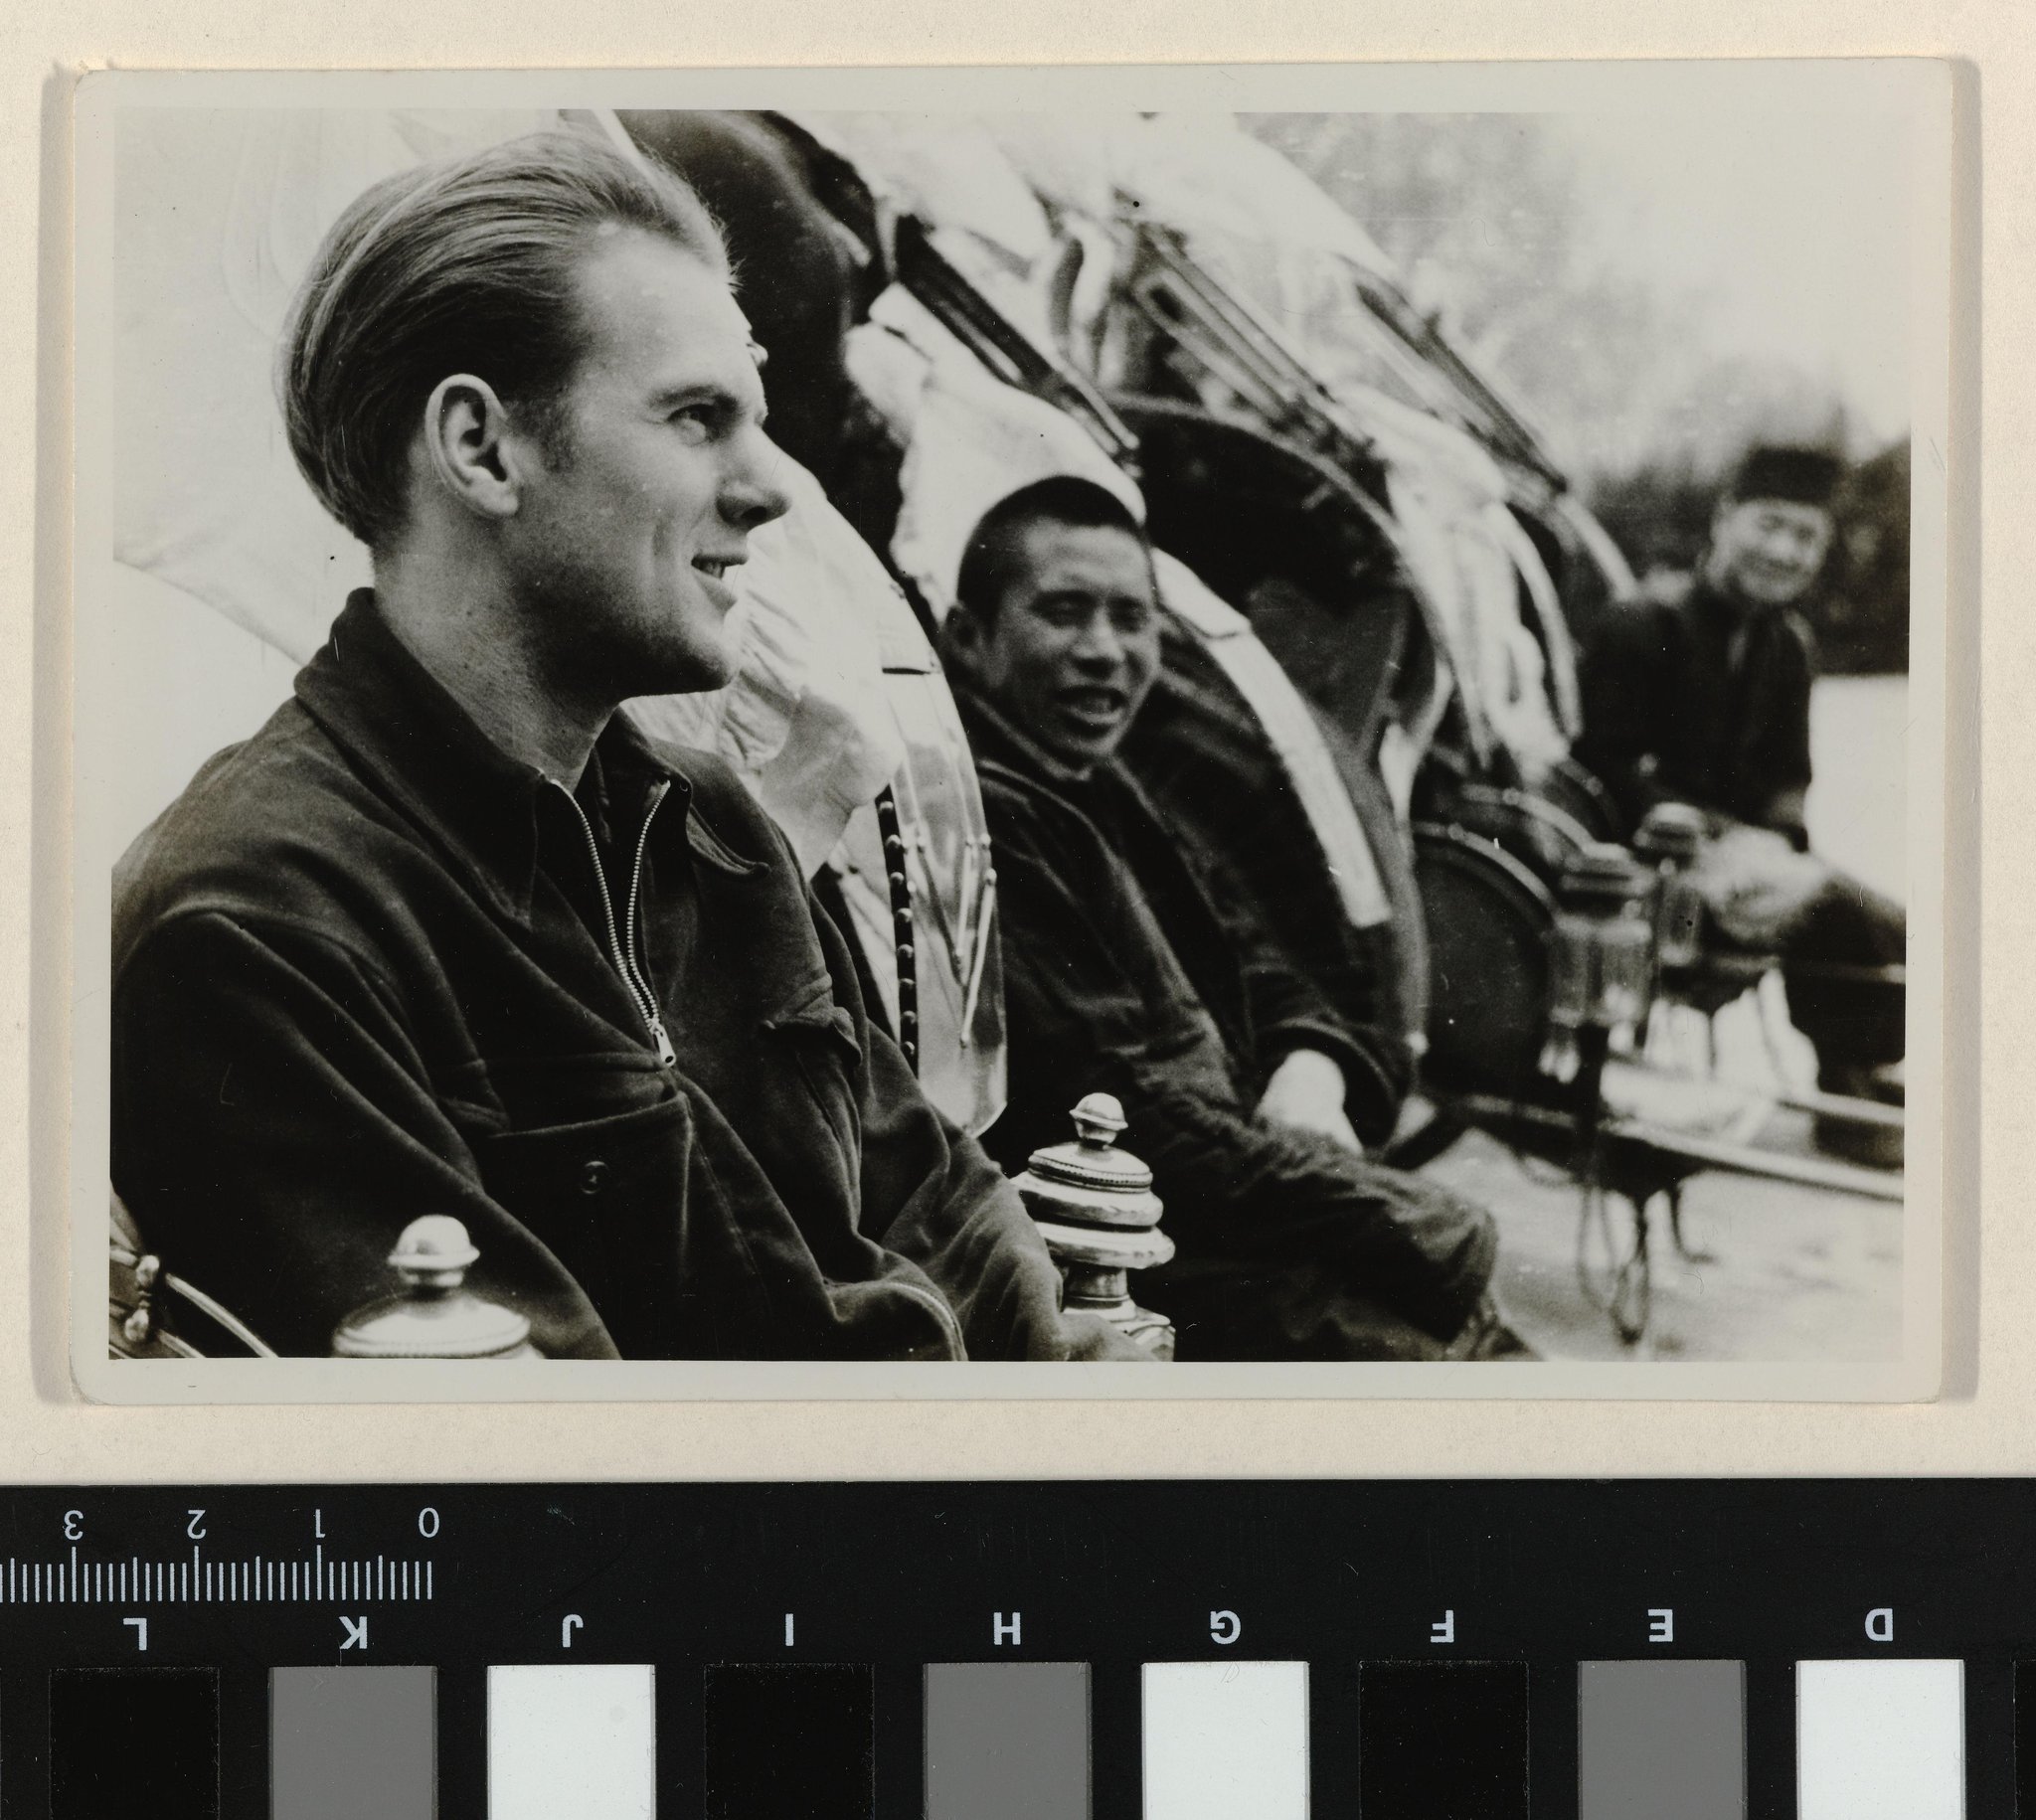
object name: photograph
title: Portret van John Fernhout in een riksja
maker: robert capa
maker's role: fotograaf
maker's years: 1913-1954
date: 1938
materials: paper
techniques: gelatin silver print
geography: china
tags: john fernhout, rickshaw, historical persons, china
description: John Fernhout zittend in een riksja, op de achtertond twee Chinezen, tevens gezeten in een riksja.